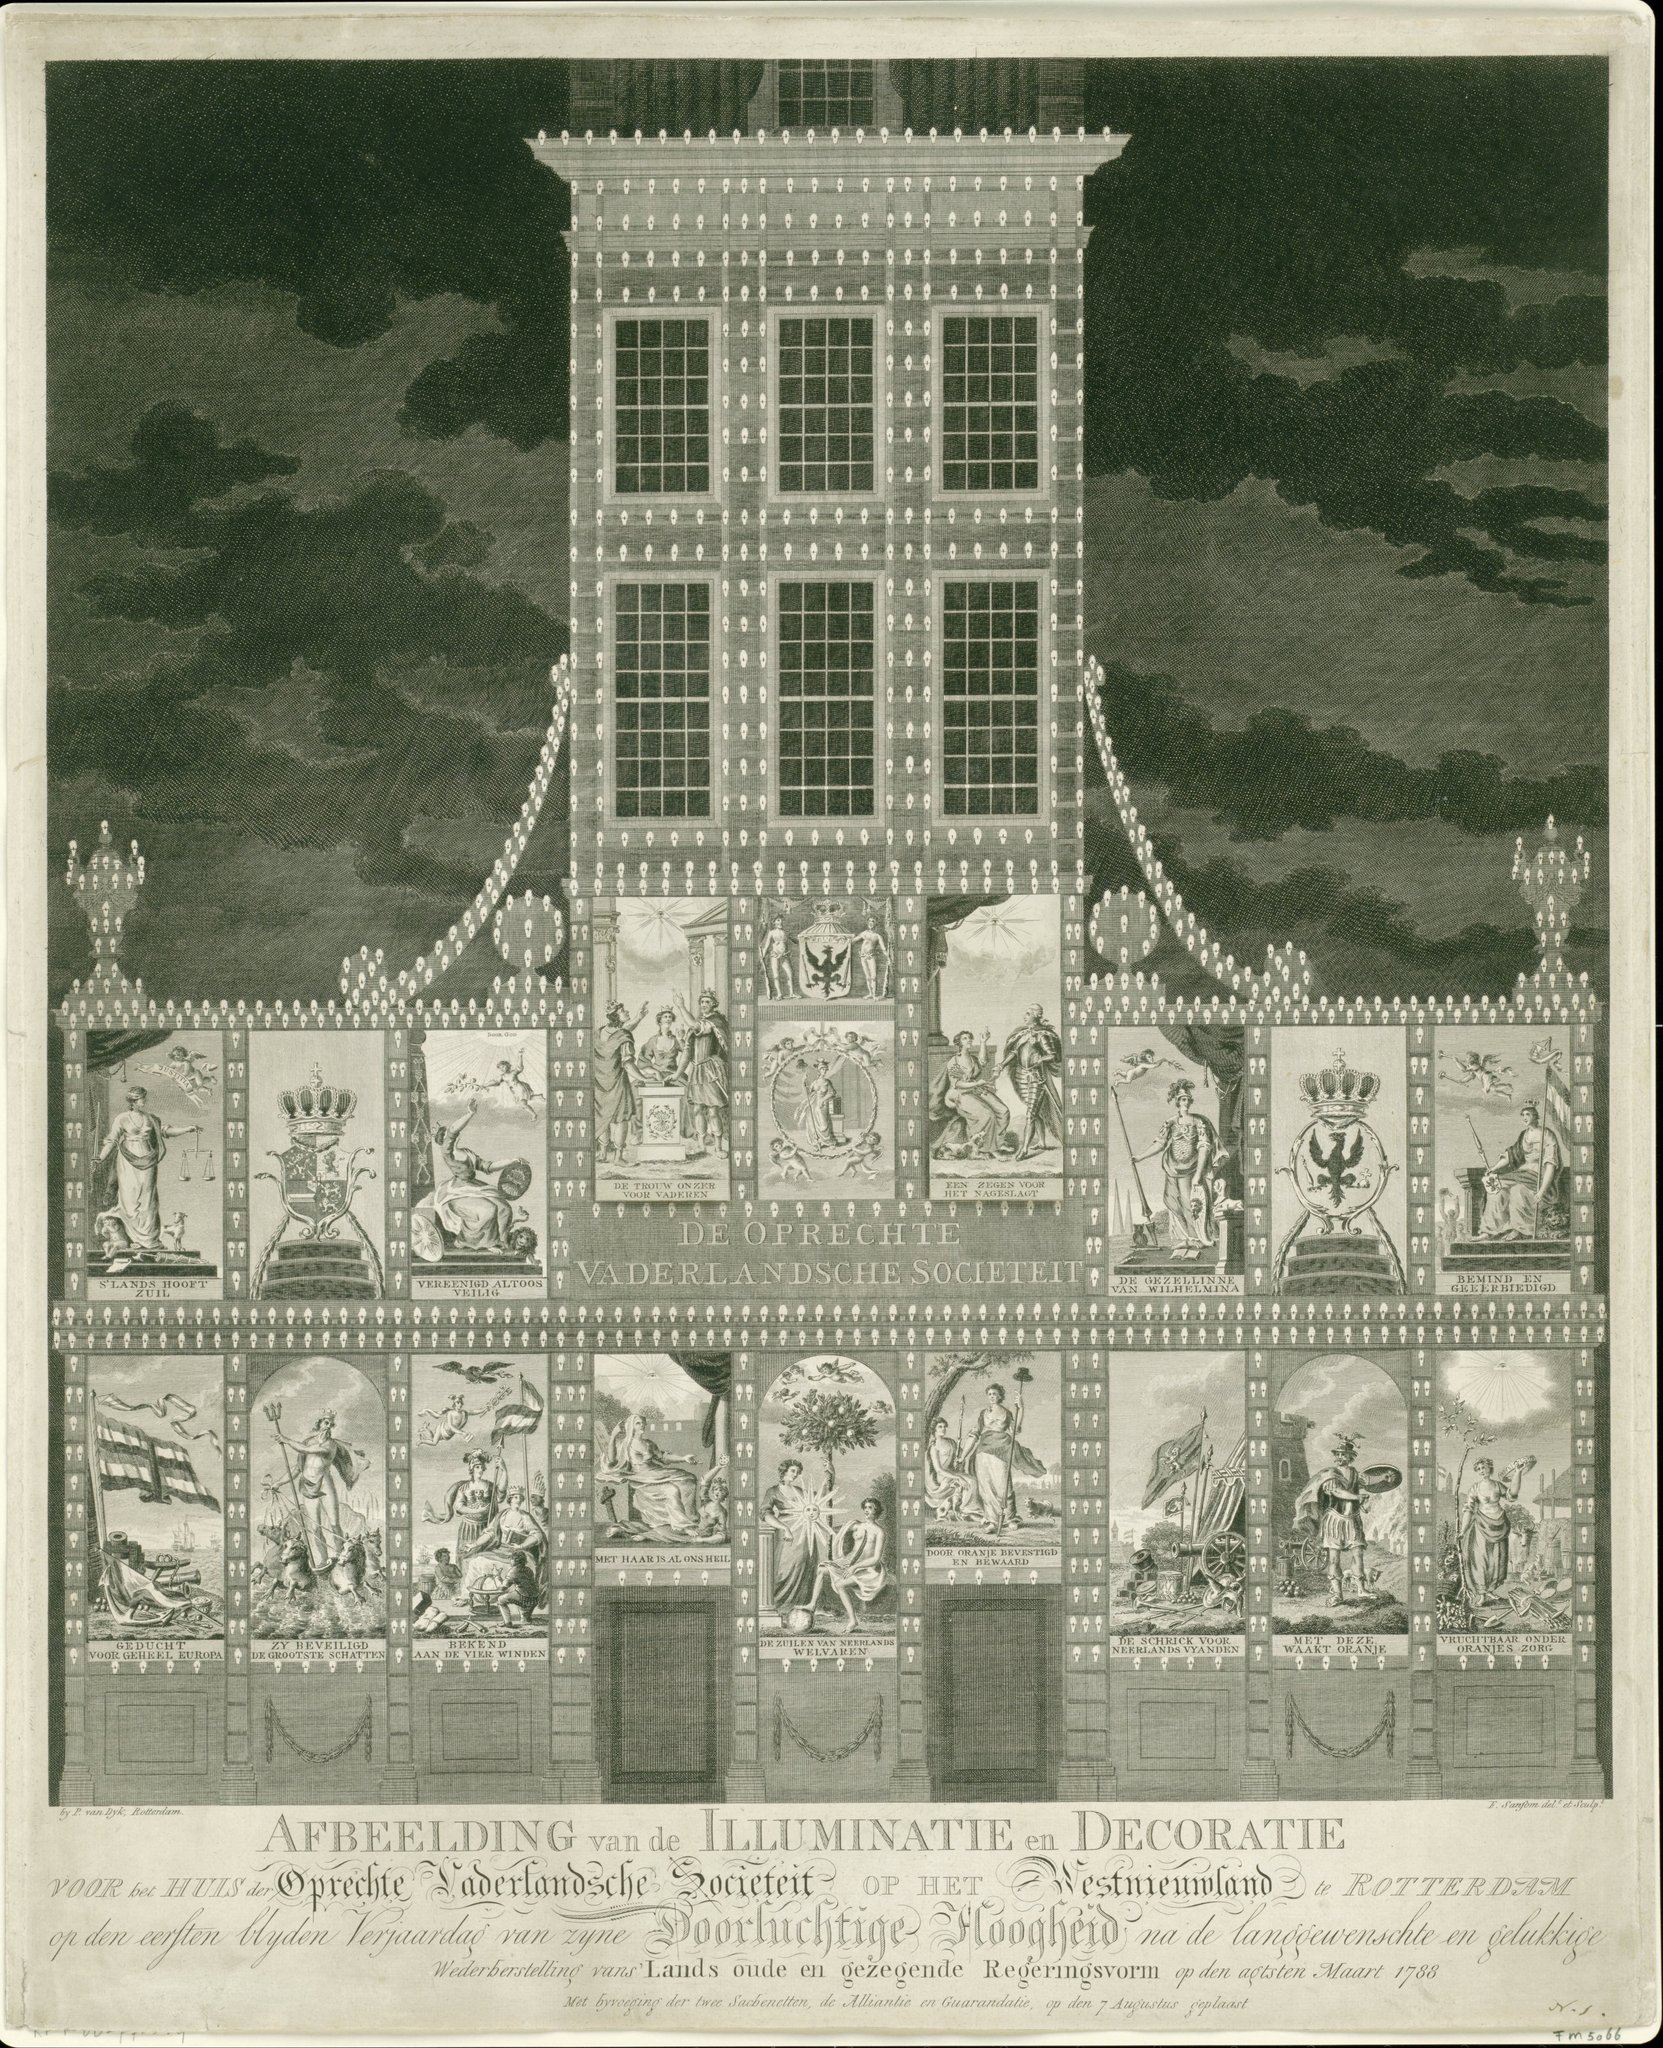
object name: print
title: Illuminatie van het pand van de Oprechte Vaderlandsche Sociëteit op het Westnieuwland te Rotterdam, 1788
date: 1788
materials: paper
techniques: engraving, etching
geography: rotterdam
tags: the hague, william v (prince of orange), bonfire, fire-works (+ illumination, fire-works ~ festive activities), rotterdam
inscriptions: collector's mark: Lugt 2228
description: Illuminatie van de gevel van het pand van de Oprechte Vaderlandsche Sociëteit op het Westnieuwland te Rotterdam, ter gelegenheid van de veertigste verjaardag van prins Willem V op 8 maart 1788 en het herstel van de oude constitutie. De gevel versierd met lichtjes en achttien chassinetten met allegorische voorstellingen, waarvan de twee die pas later op 7 augustus zijn geplaatst op losse, opklapbare blaadjes.